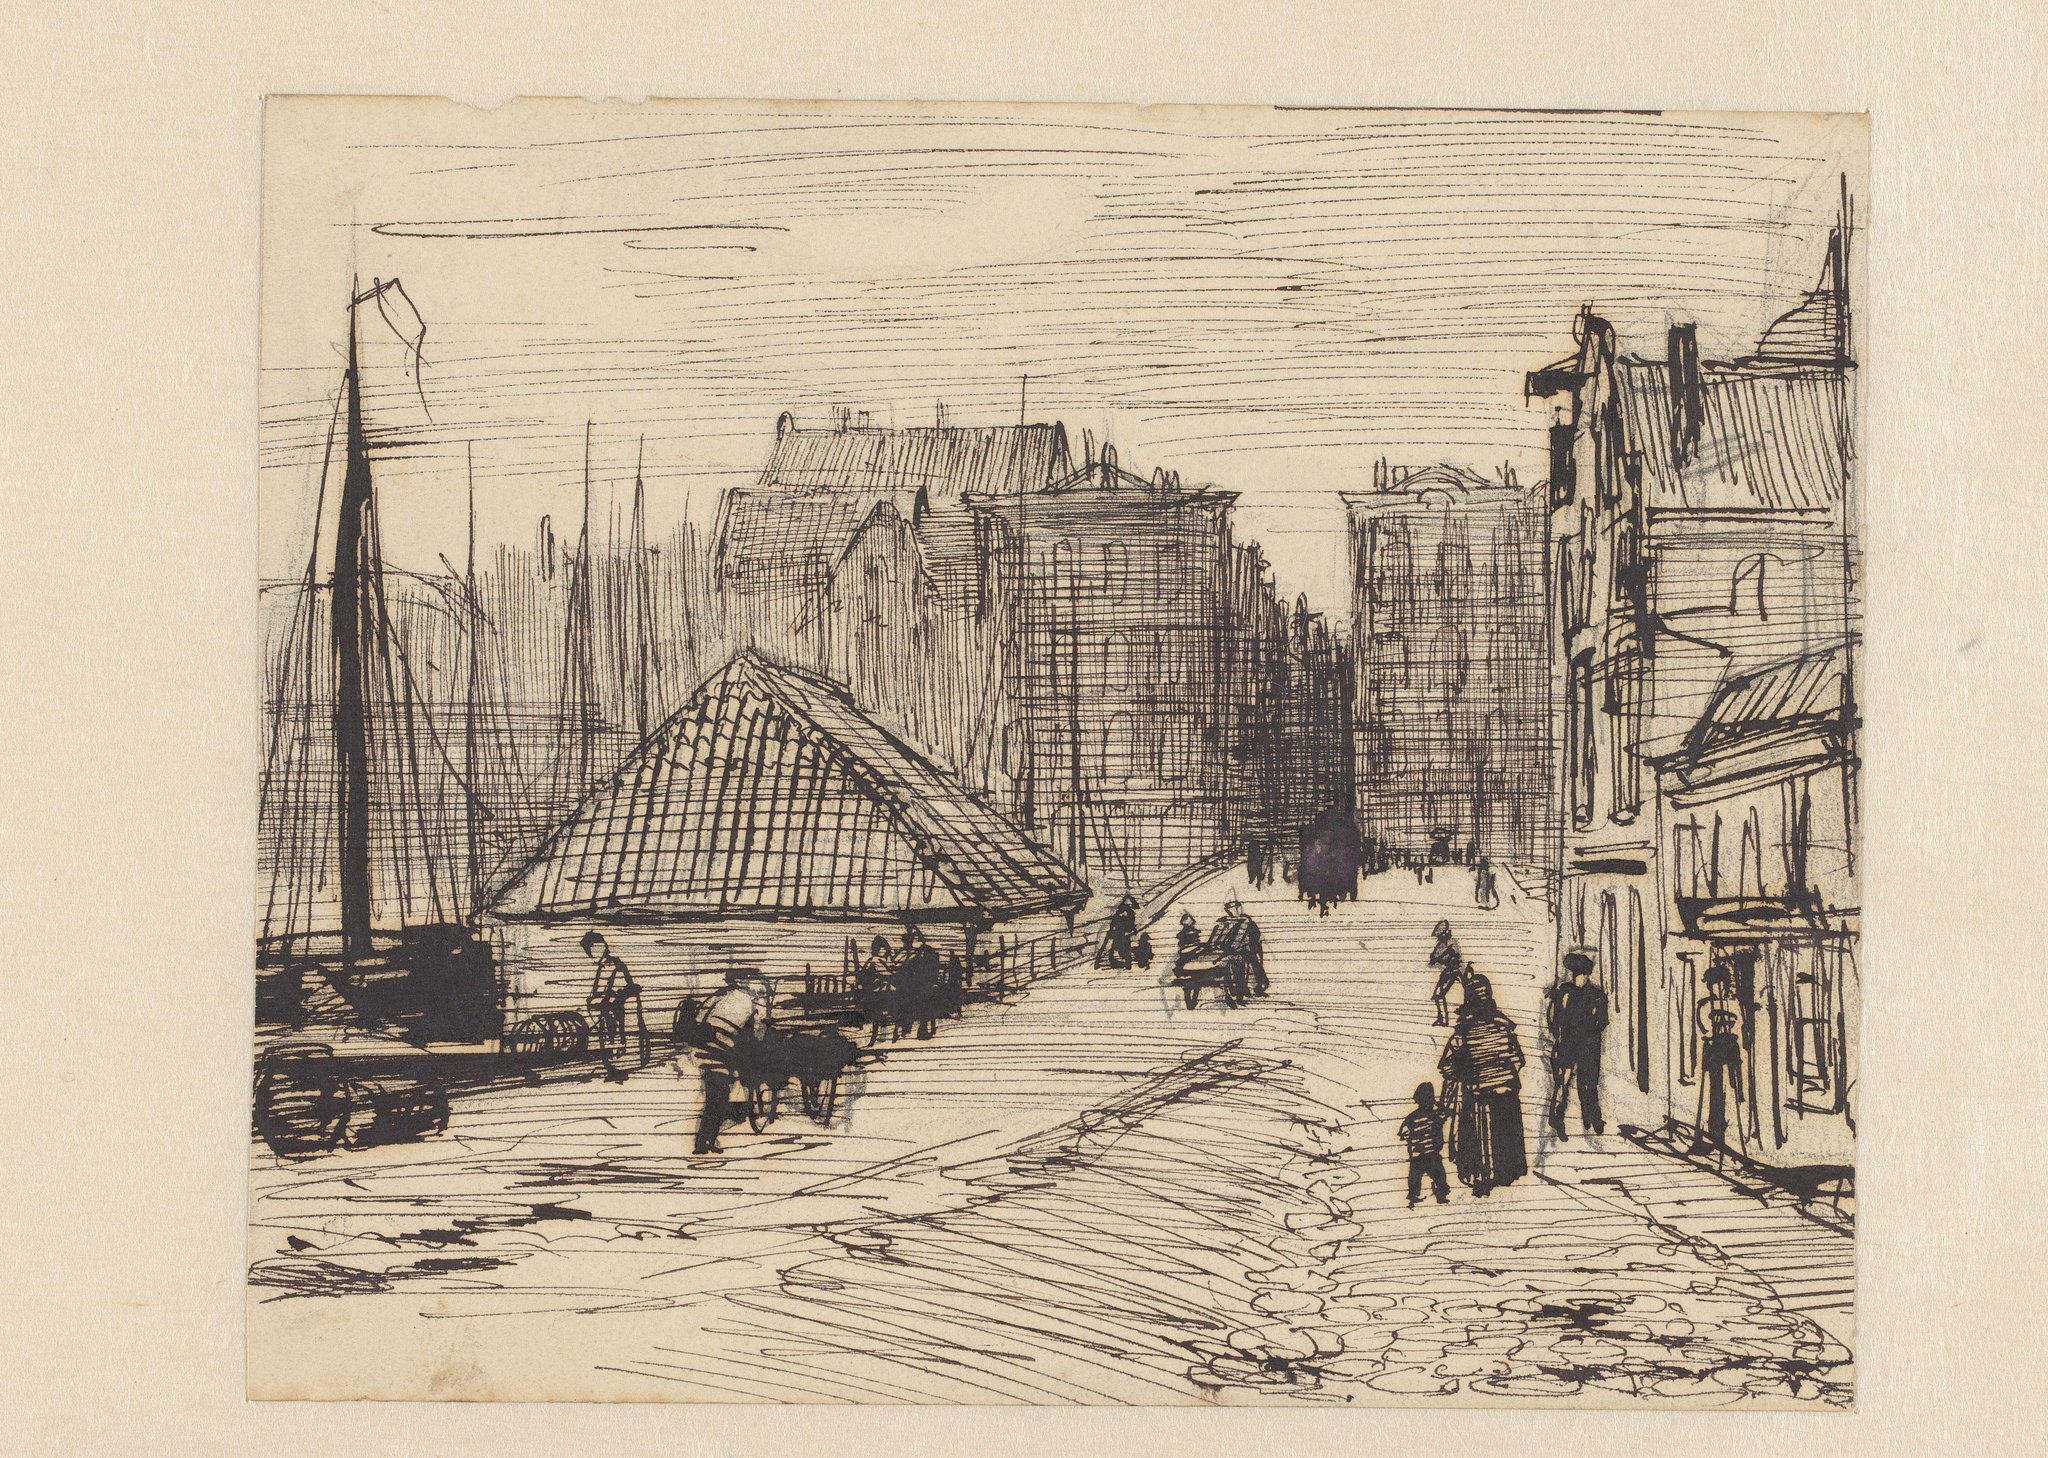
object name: drawing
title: Kade in een stad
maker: coen metzelaar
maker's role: draughtsman, painter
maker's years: 1845-1881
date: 1855-1881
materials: ink, paper, pencil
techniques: pen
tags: quay